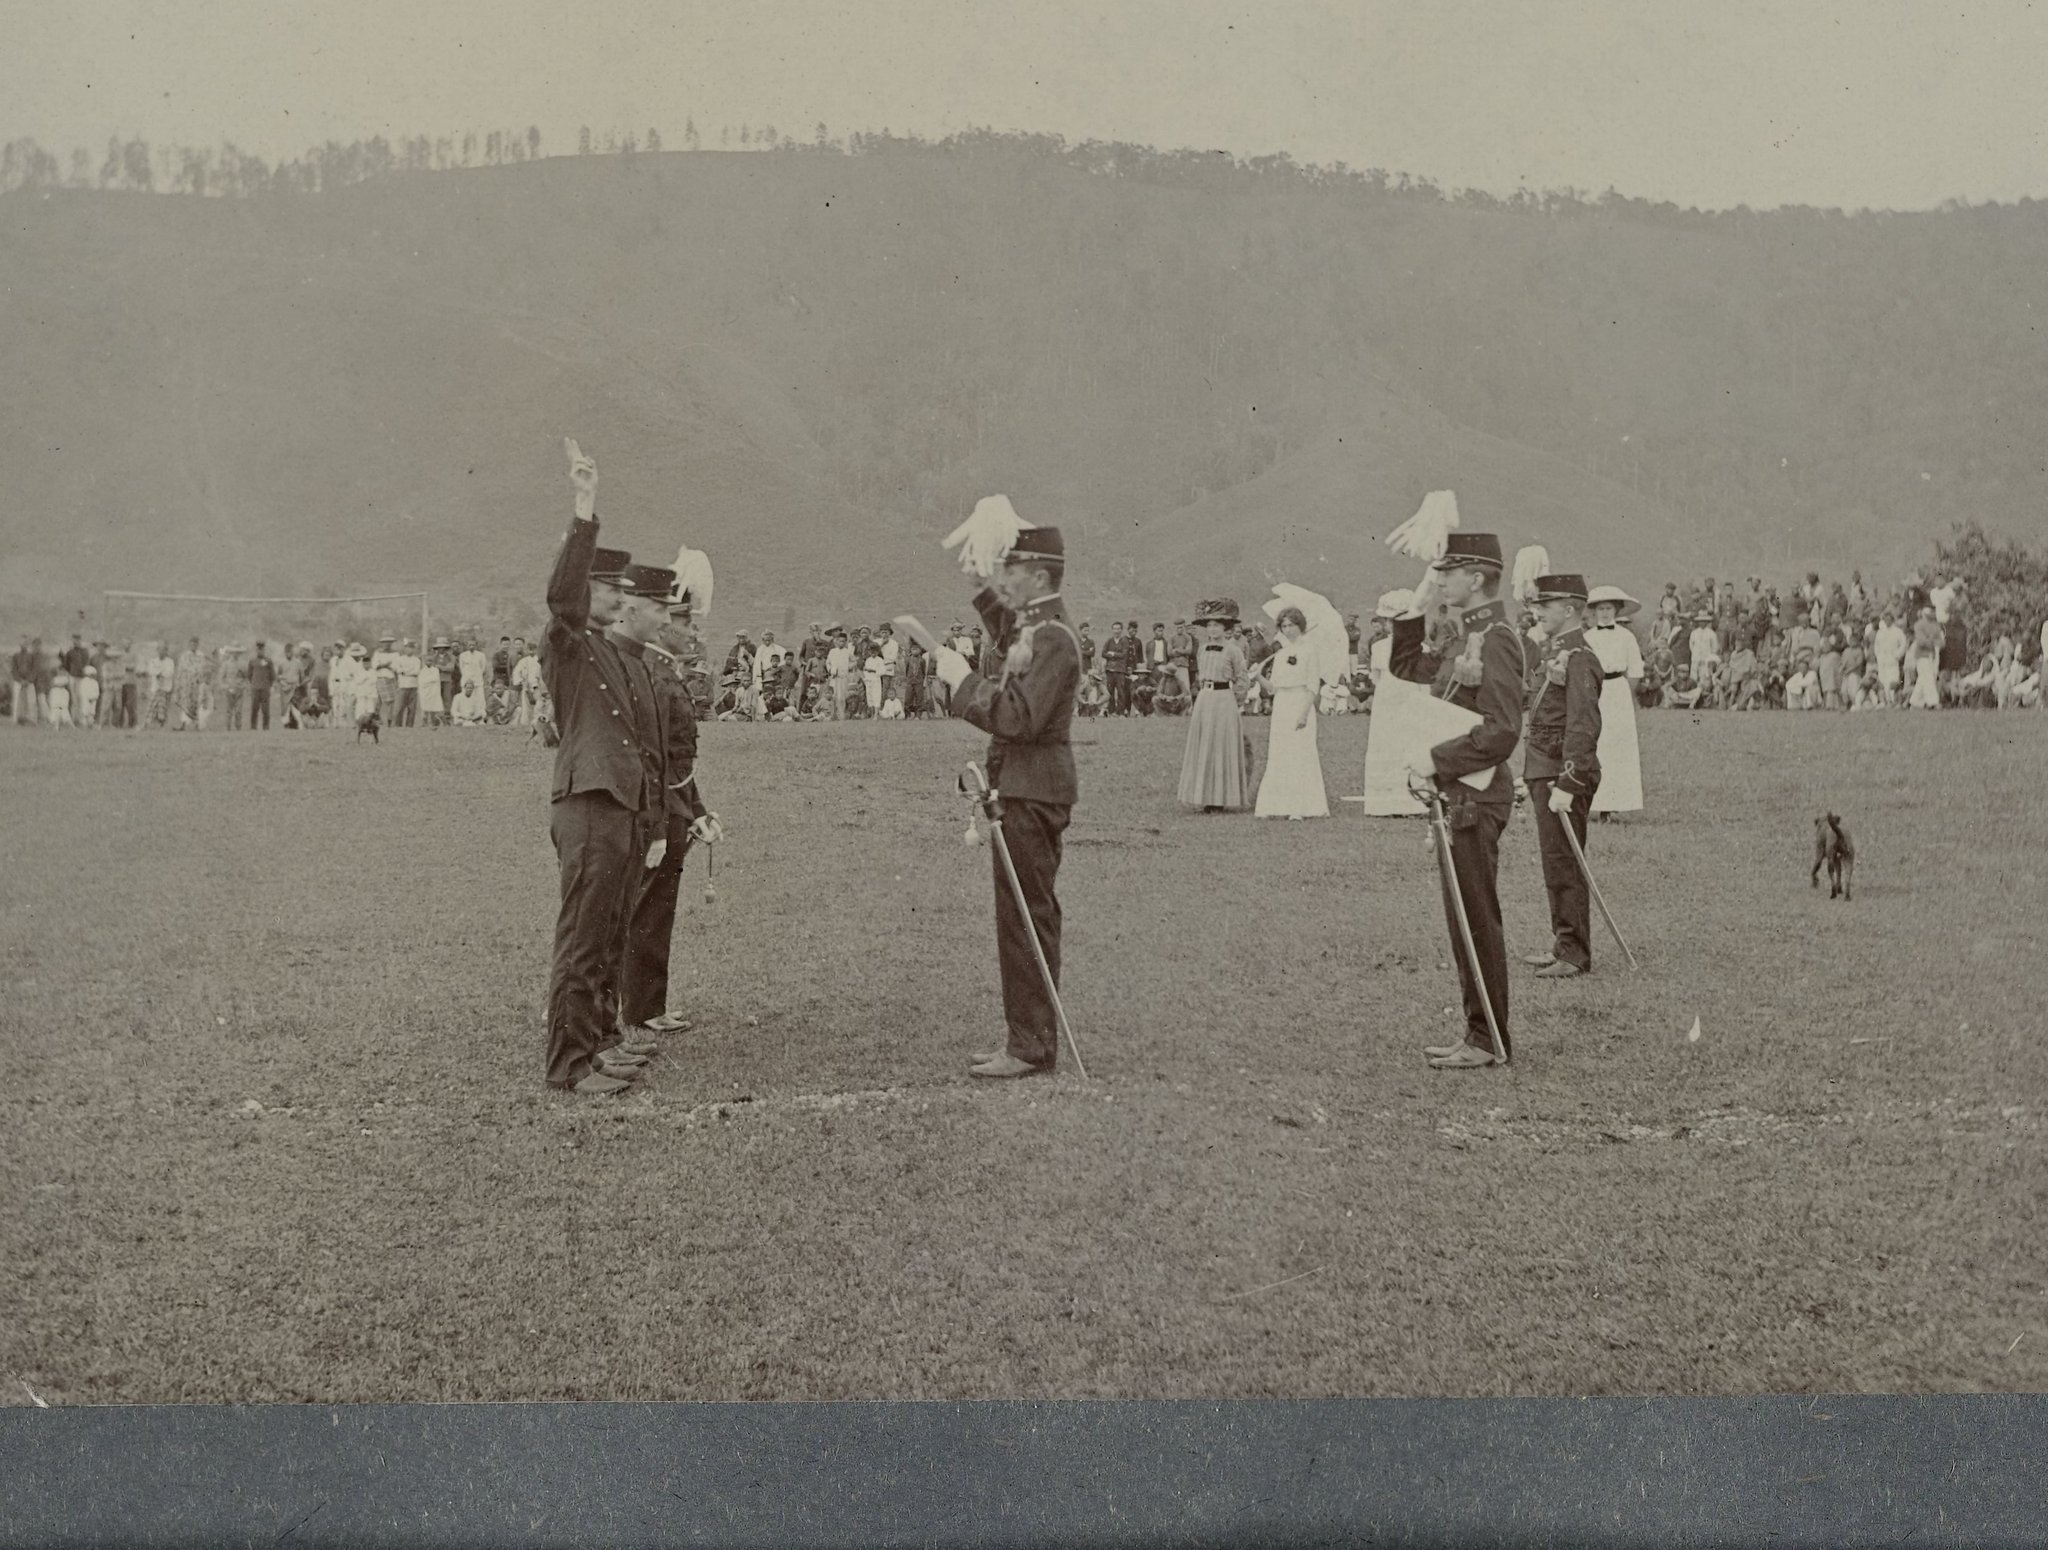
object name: photograph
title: Beëdiging van officieren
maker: Anonymous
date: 1903-1913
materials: photographic support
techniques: gelatin silver print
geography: north sumatra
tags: arnhem, the hague, albertus dominicus laman trip, building activities, traffic by road or path with motor-vehicle, landscapes in tropical and sub-tropical regions, road, path, military celebrations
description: Na de expedities naar de Gajo- en Alaslanden o.l.v. Van Daalen (eerste tocht in 1901), werd hij in 1903 belast met voorbereiding van permanente vestiging van Nederlands gezag. Aanleg van een weg van de Noordkust naar het binnenland was hierbij van groot belang. Deze zgn. Gajoweg werd aangelegd tussen 1903 en 1914, van Bireuen aan de kust naar Takinguen aan het bergmeer Danau Lauttawar, totale lengte 104 km.